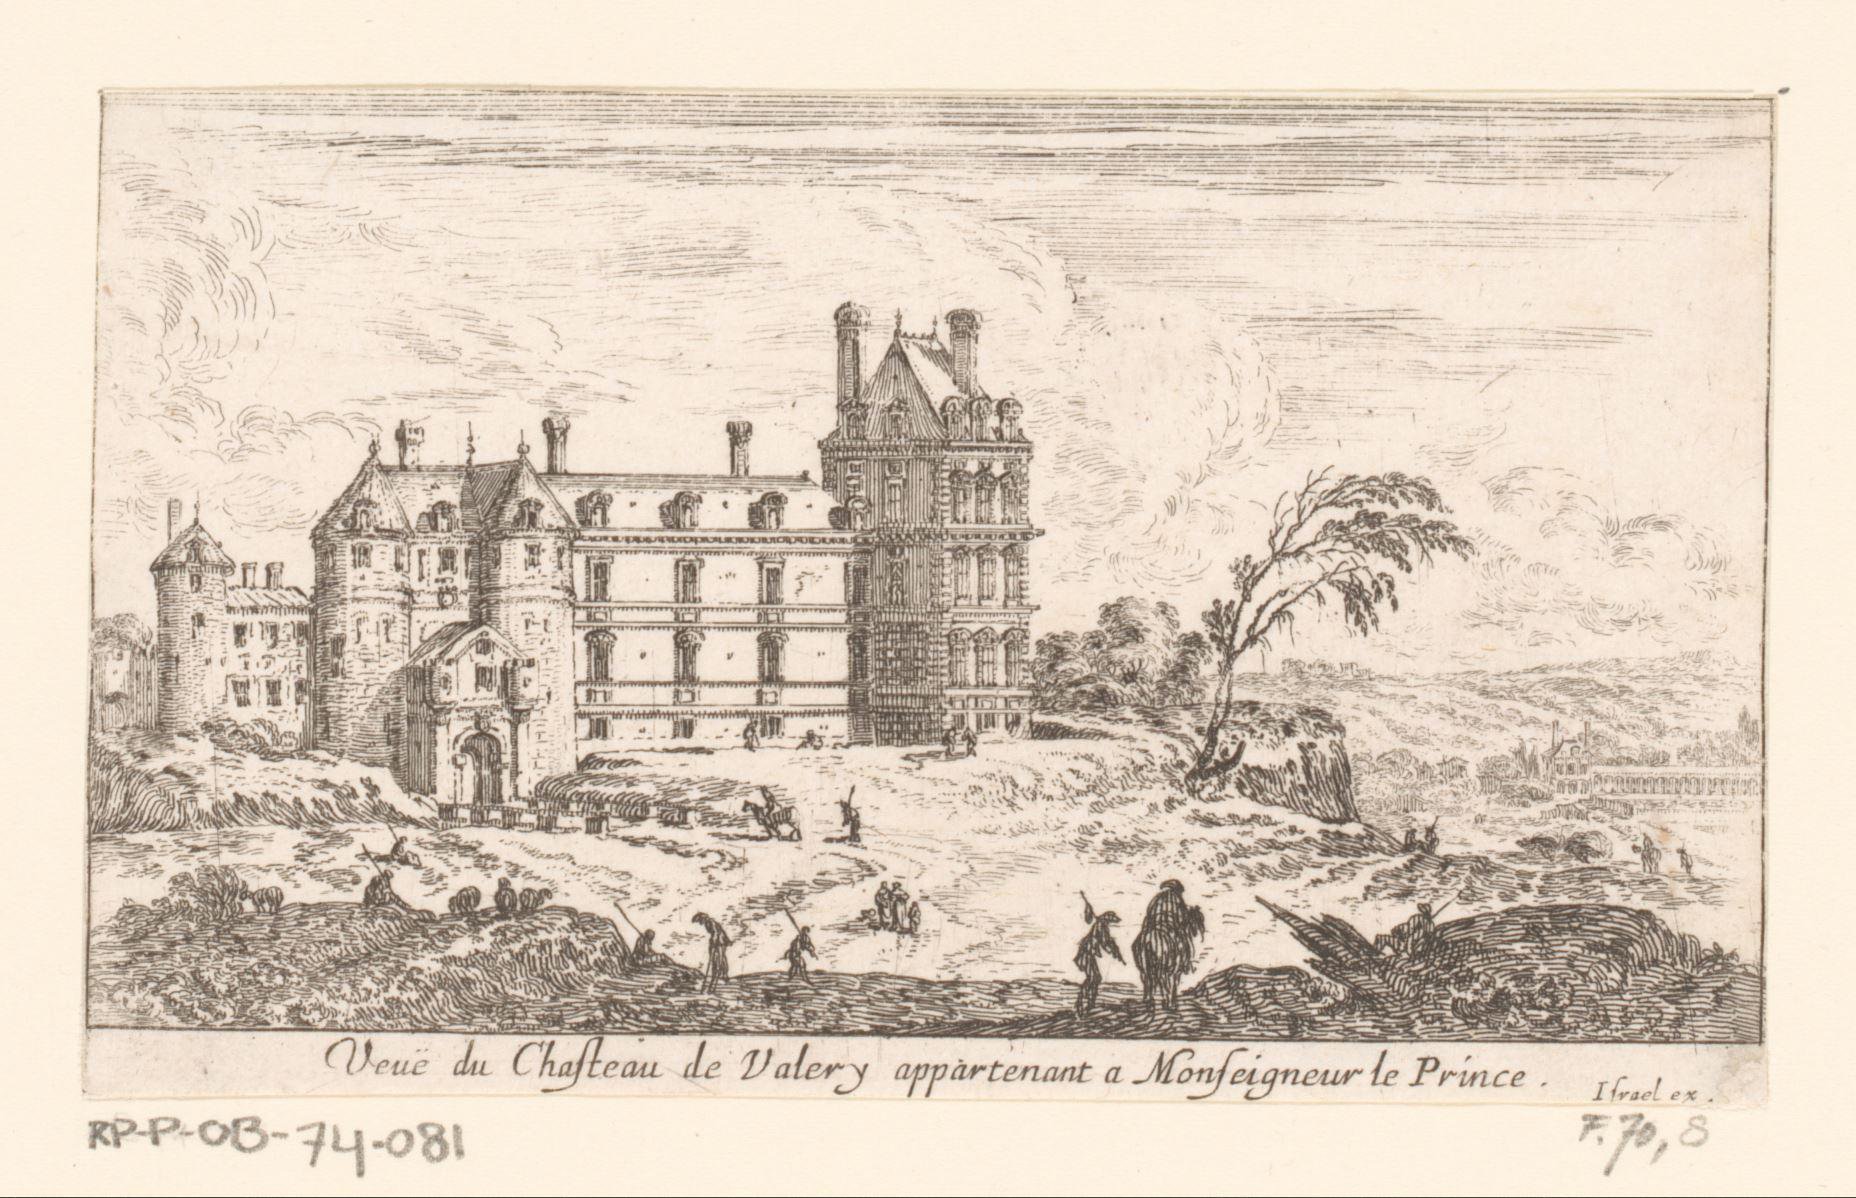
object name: print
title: Veue du Chasteau de Valery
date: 1631-1661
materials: paper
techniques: etching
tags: landscape with tower or castle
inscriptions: collector's mark: Lugt 240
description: Prent maakt deel uit van een ongenummerde serie van acht prenten.